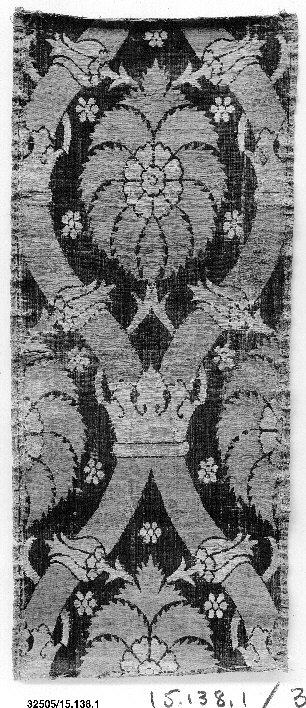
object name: textile fragment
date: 1501-1600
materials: velvet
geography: turkey